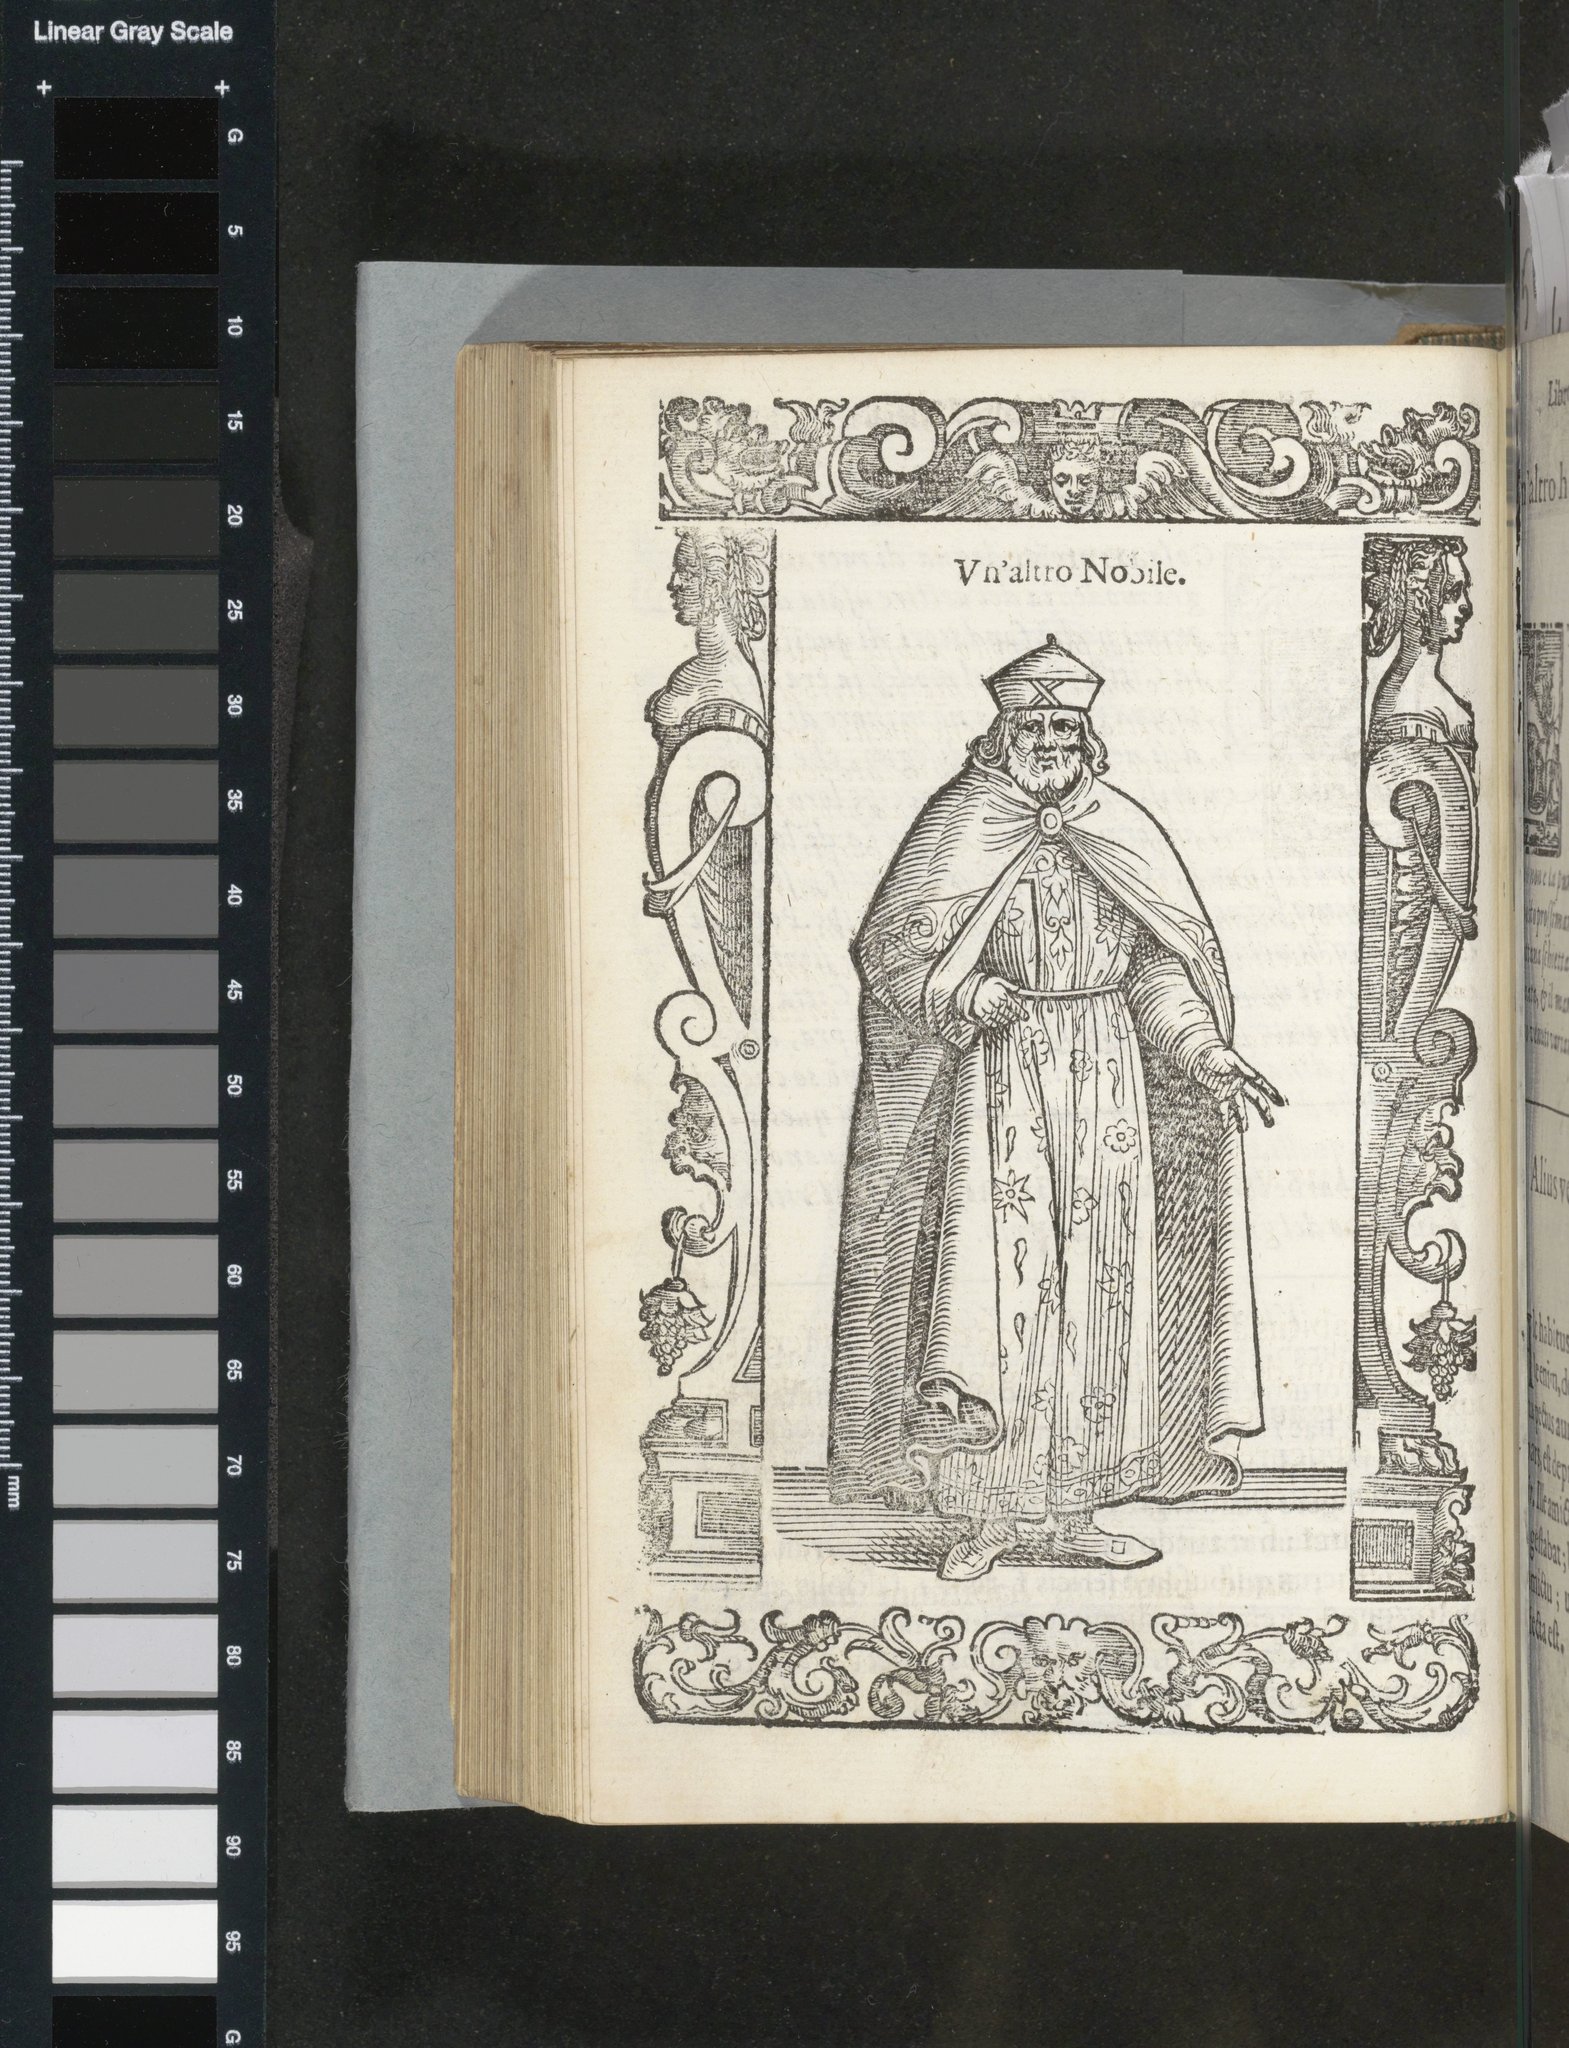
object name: costume print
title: Un’altro nobile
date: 1598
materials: paper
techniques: woodcut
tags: europeans (venetians) (+ costume), cape, head-gear: hat (+ men's clothes)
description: Het kostuum van een adellijk heer uit Venetië: geborduurde sottana waarover een losse schoudermantel. Ronde hoed met puntige bol. In ornamentrand.